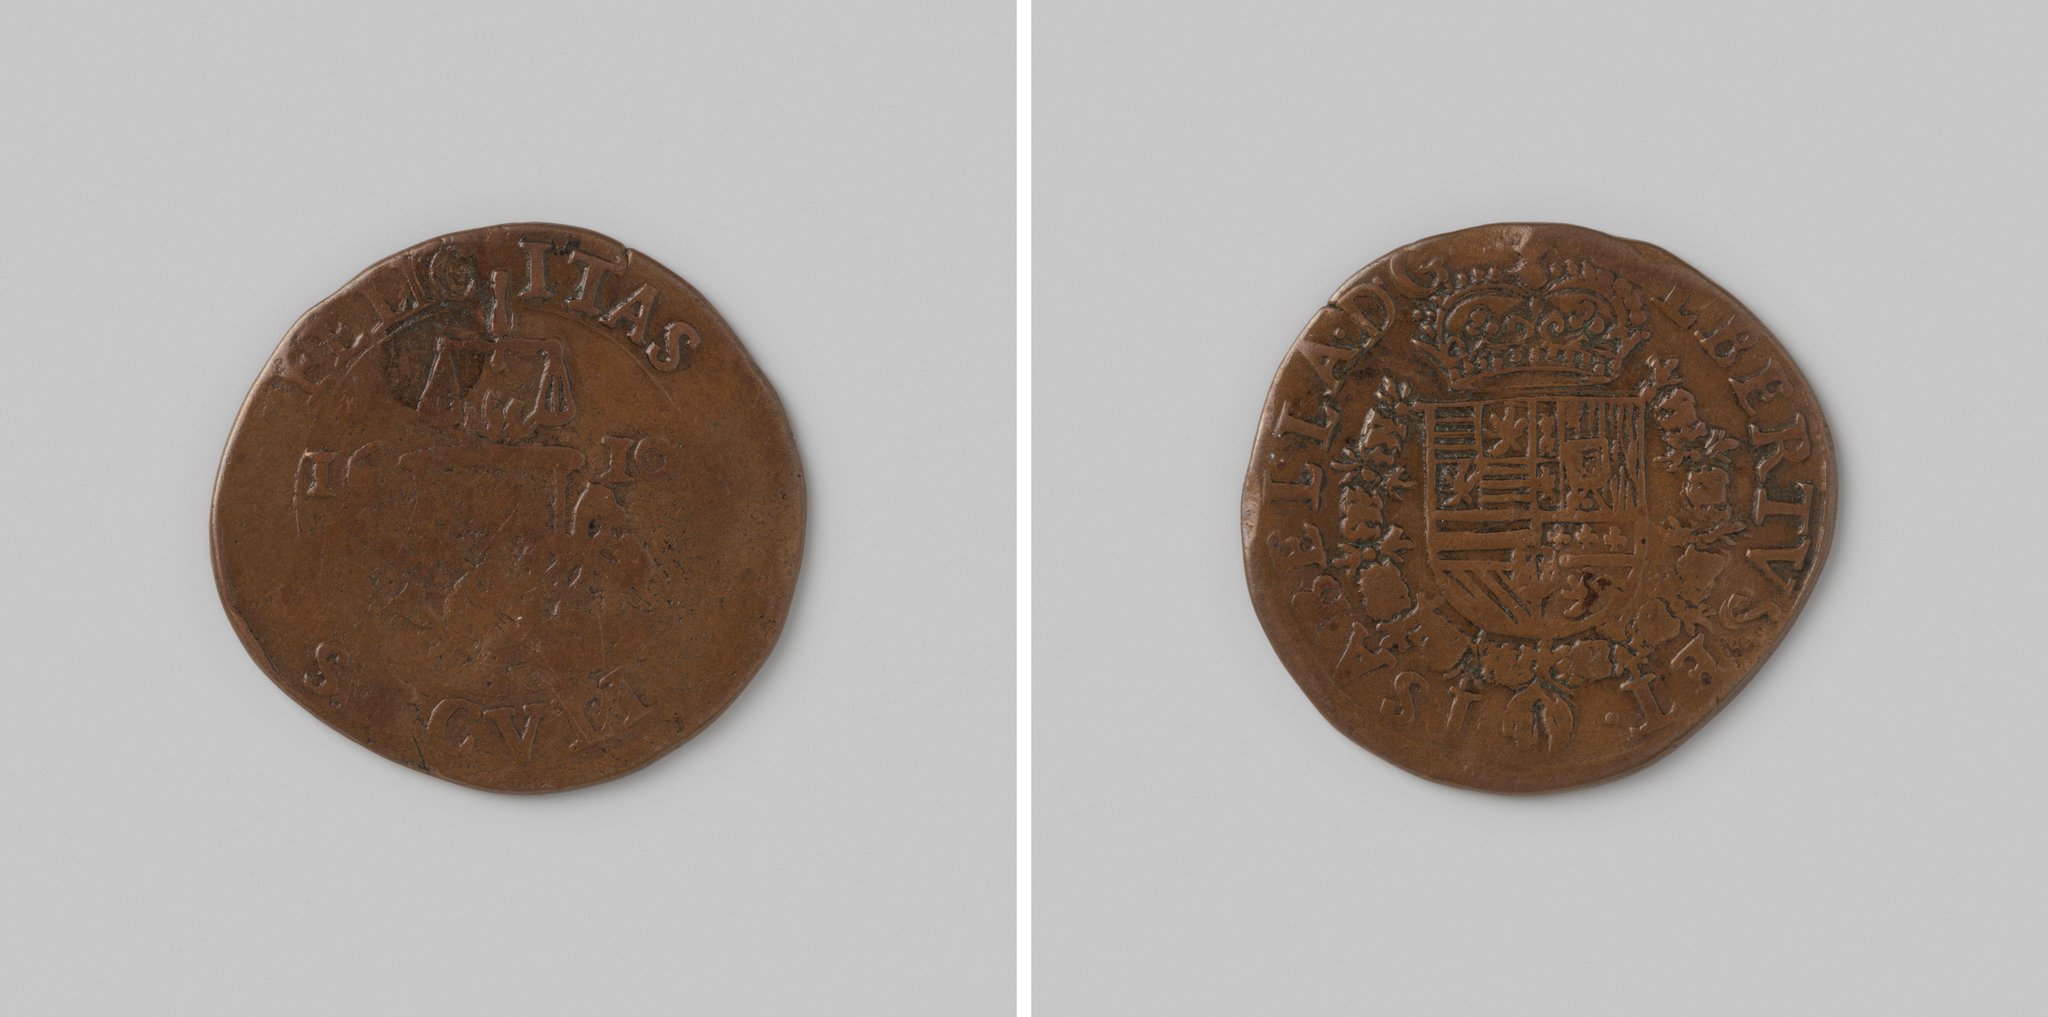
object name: jeton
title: Rekenpenning op de rechtvaardigheid van de Aartshertogen en de voorspoedige tijden 1610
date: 1610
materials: copper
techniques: striking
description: Koperen penning, op de voorzijde een altaar waartegen een roer, een mercuriusstaf en een globe, bovenaan een weegschaal, met jaartal in het veld en omschrift, op de keerzijde het gekroonde Spaanse wapenschild omhangen met de keten van het Gulden Vlies, met omschrift.